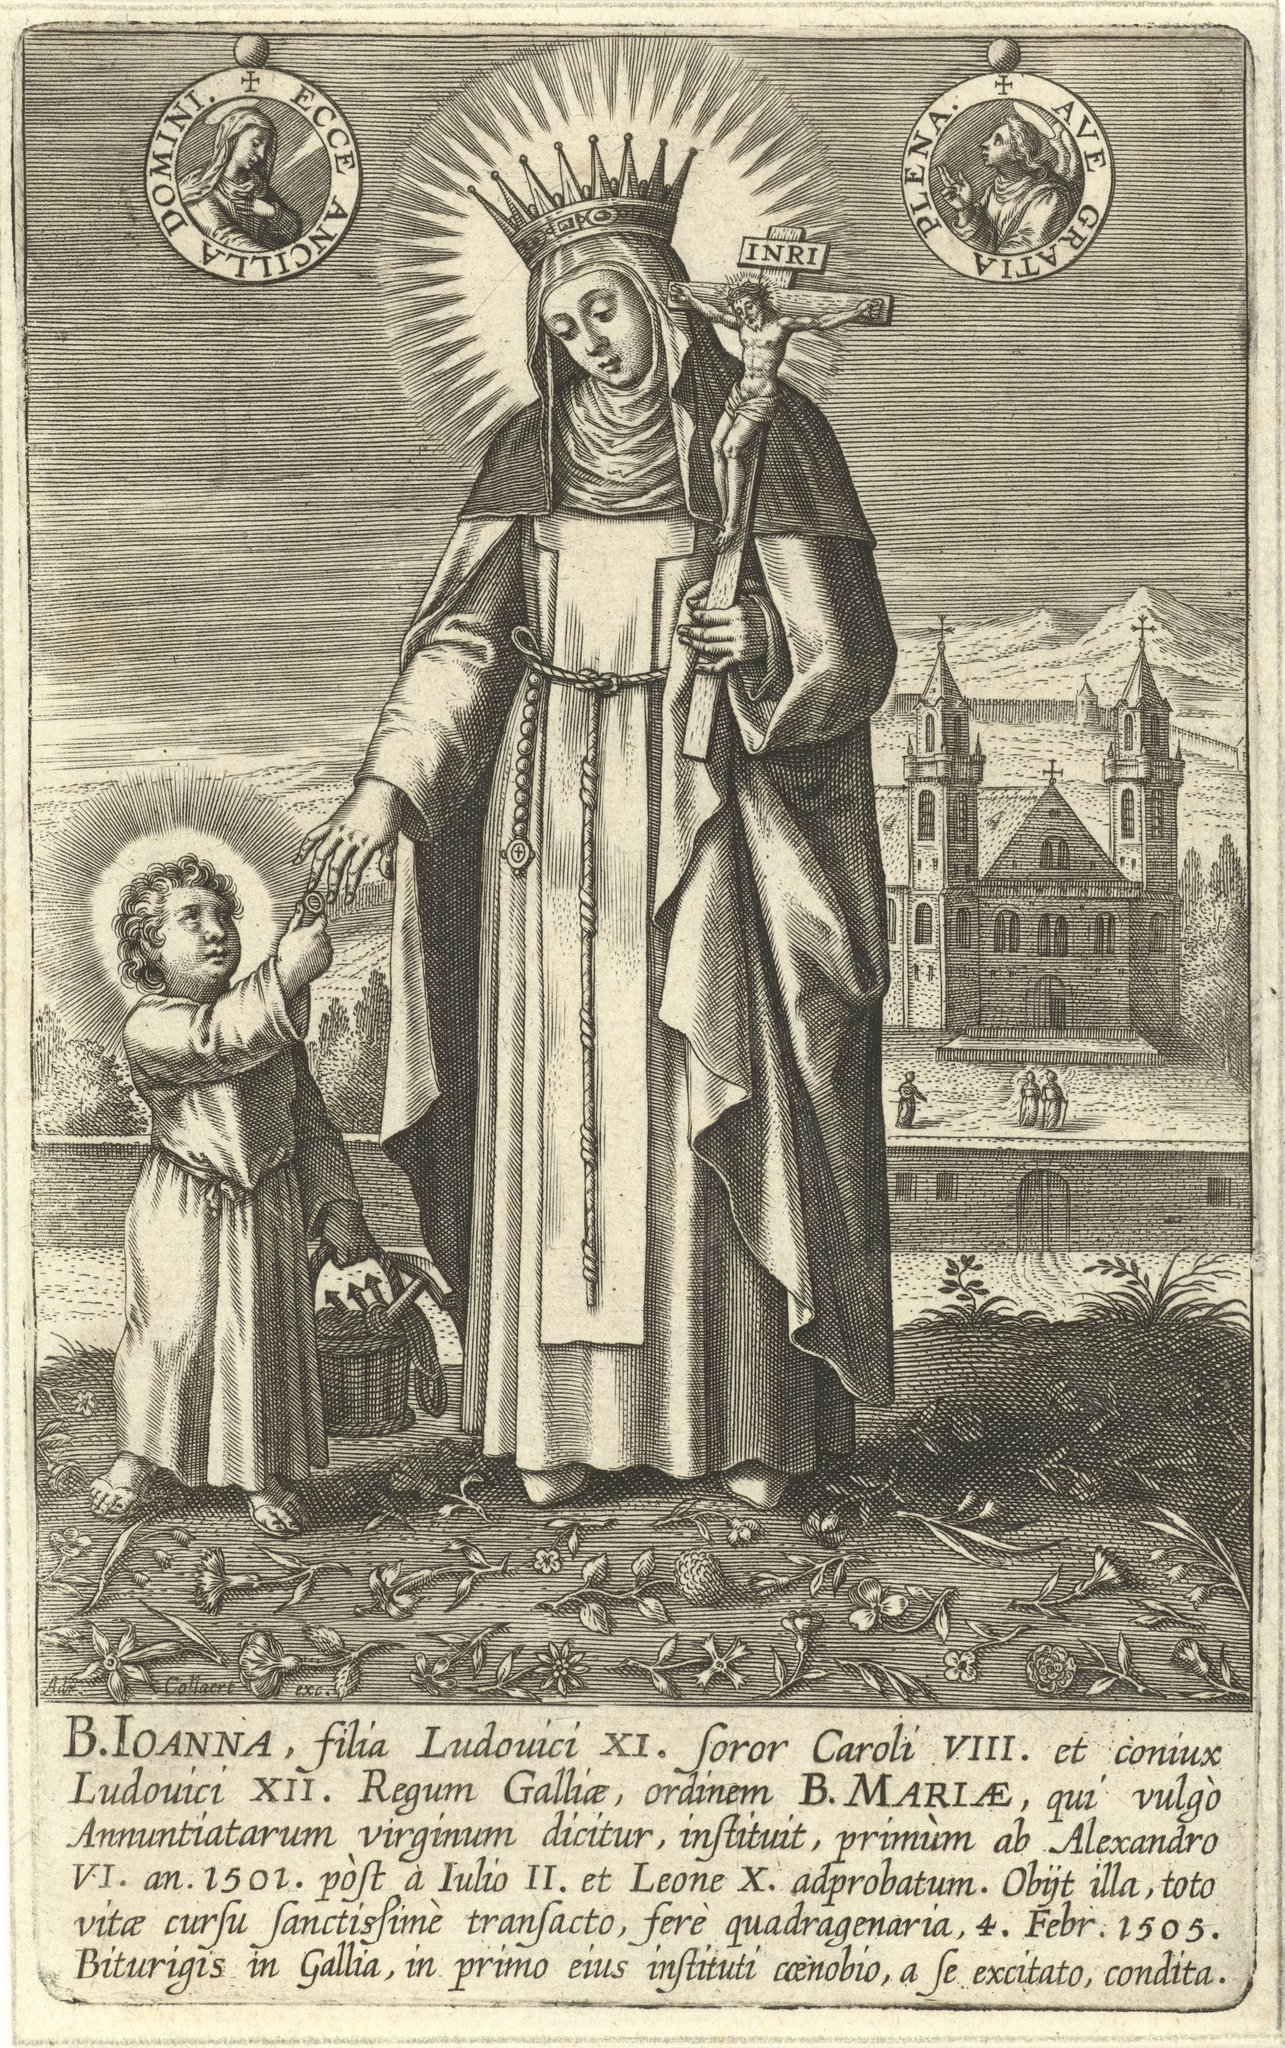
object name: print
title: Stichters van kloosters en religieuze orden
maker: adriaen collaert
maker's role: draughtsman, print maker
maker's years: 1560-1618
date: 1608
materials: paper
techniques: engraving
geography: antwerp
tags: female saints (with name)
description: De Heilige Johanna van Frankrijk, ze draagt een kroon en heeft een kruisbeeld in de hand. Het Christuskind staat naast haar met een mandje met de werktuigen van de passie. Hij doet een ring om haar vinger. De Heilige Johanna van Frankrijk was de oprichter van de orde van de Annunciaten. Op de achtergrond een van haar kerken. De prent heeft een Latijns onderschrift. De prent is deel van een serie met stichters van kloosters en religieuze orden.